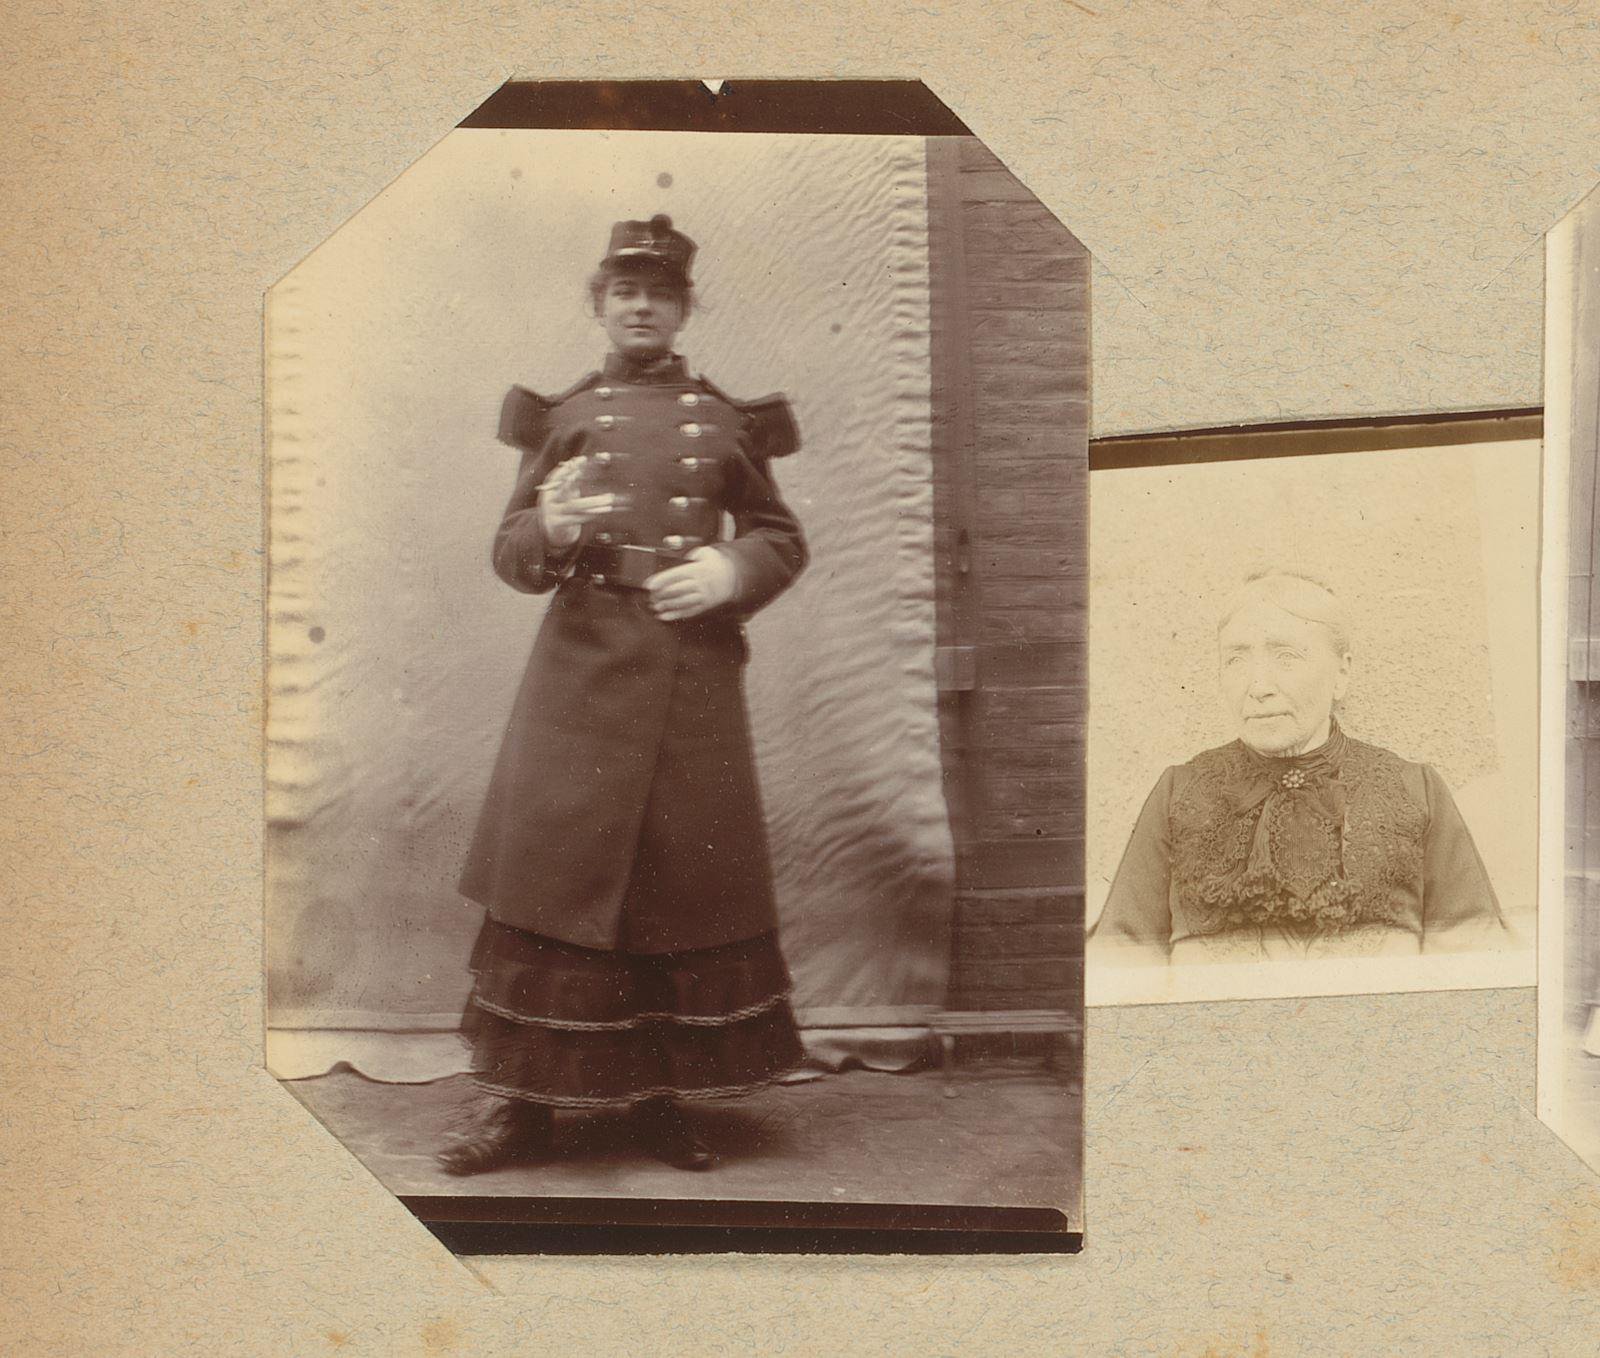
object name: photograph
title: Portret van een vrouw in militair uniform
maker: Anonymous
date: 1897-1900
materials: paper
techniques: gelatin silver print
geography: france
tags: adult woman, historical persons, (military) uniforms, france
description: Over de foto is een ander negatief afgedrukt van een voorstelling van bomen.